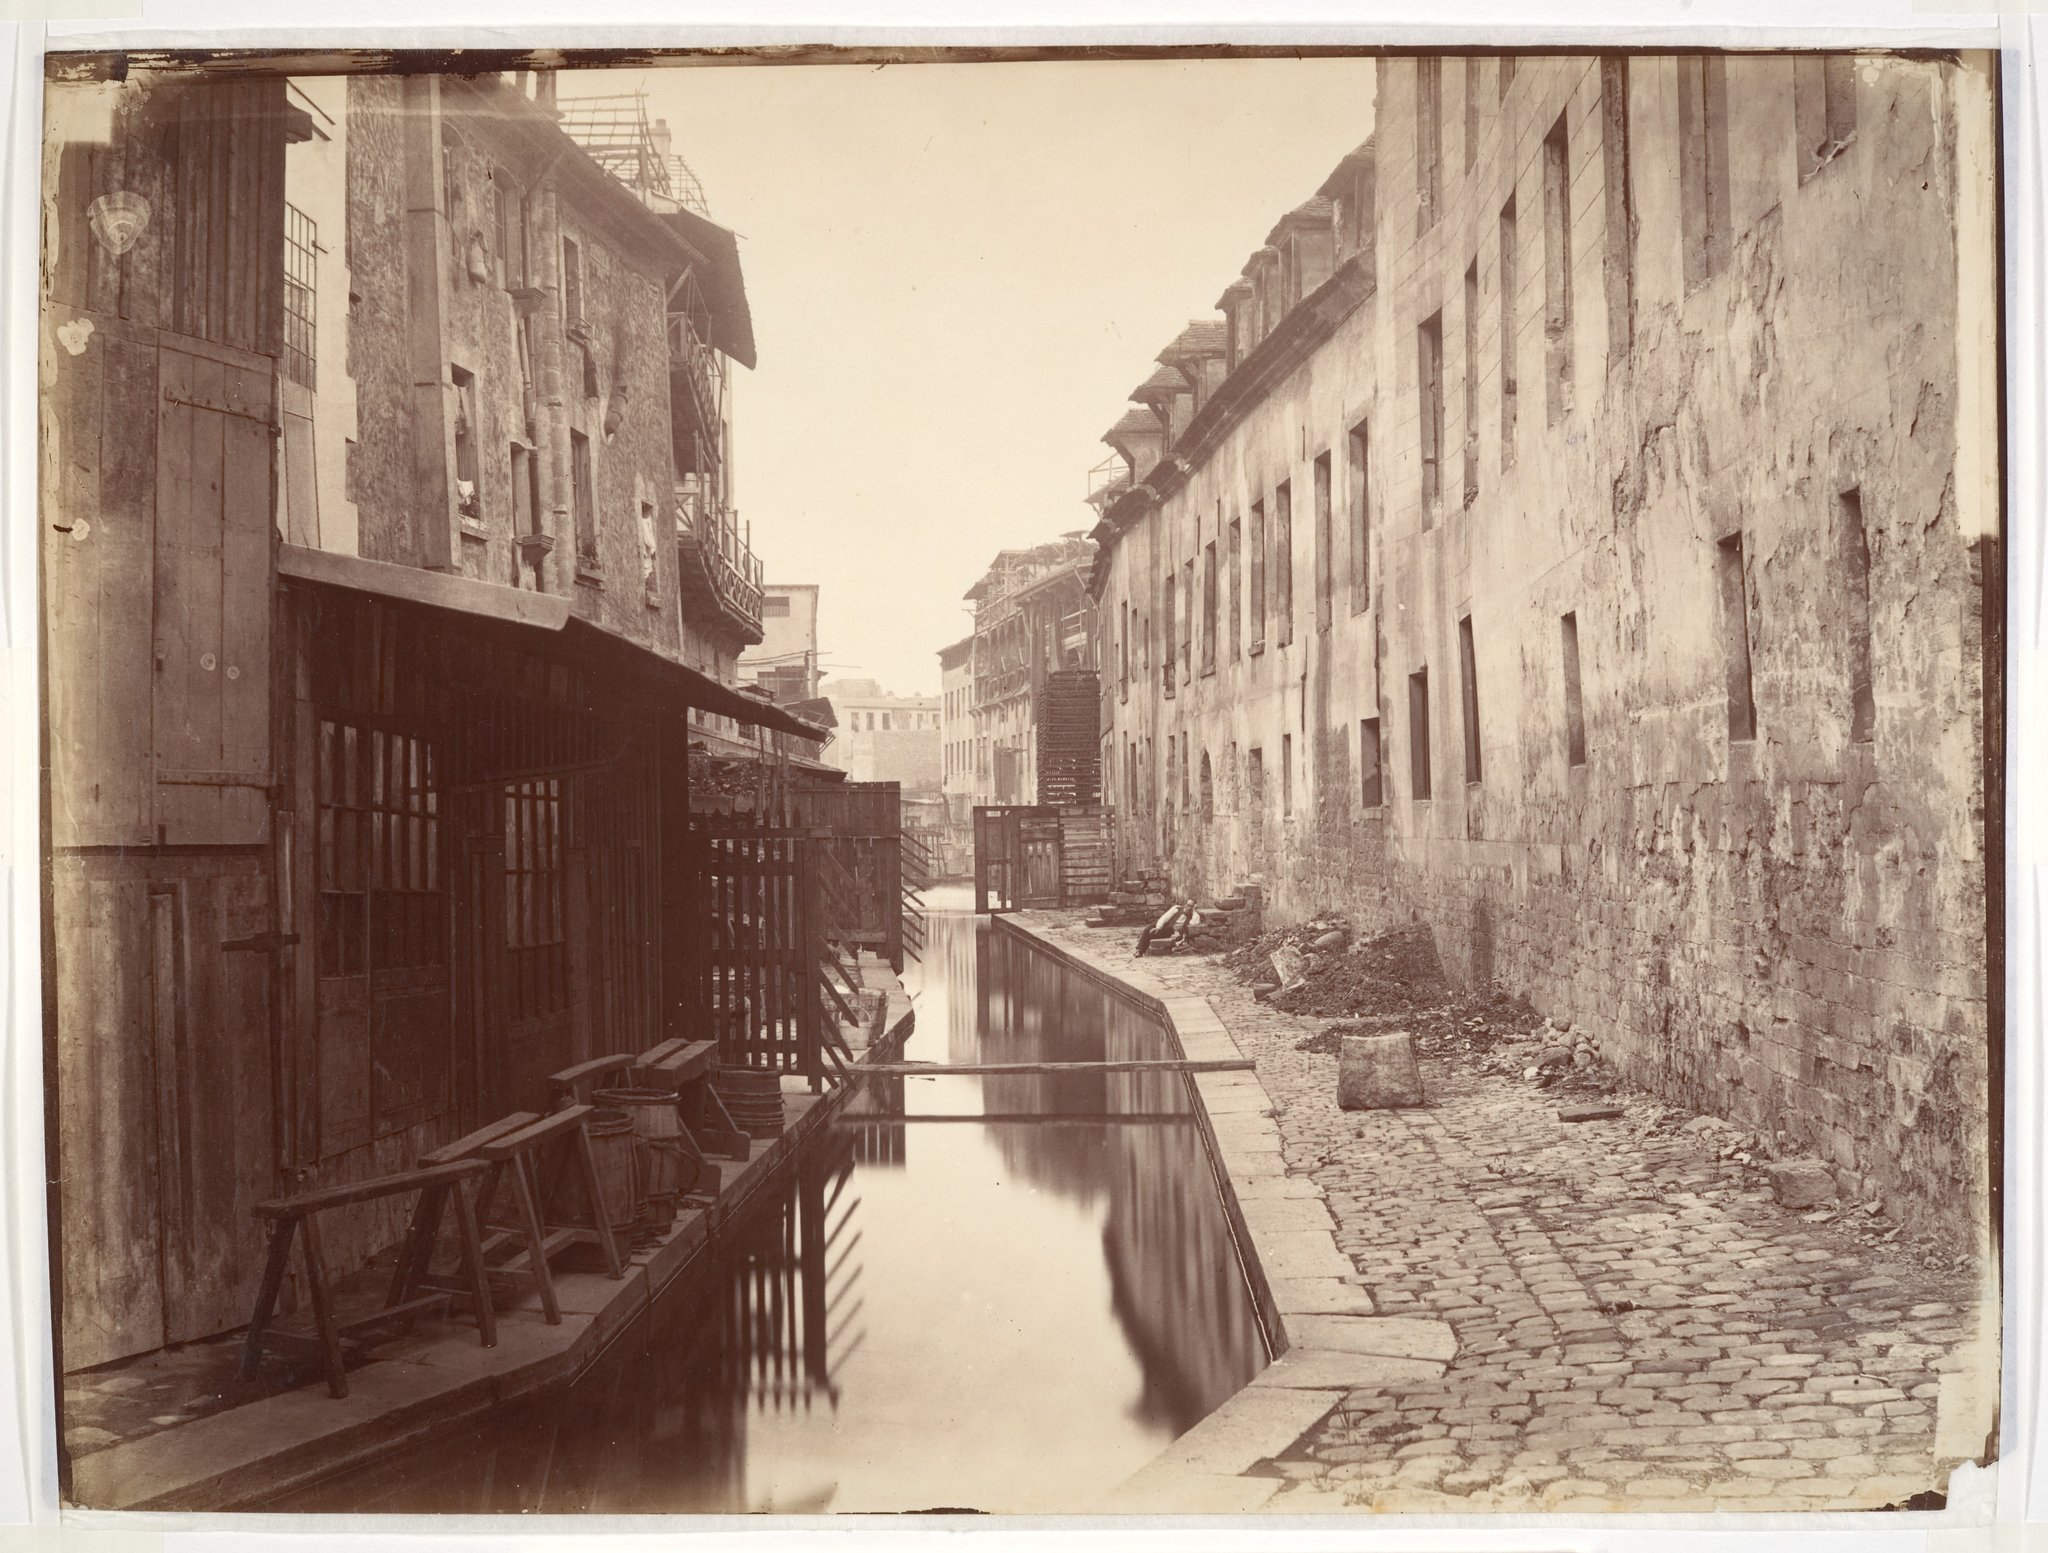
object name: photograph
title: La Bièvre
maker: charles marville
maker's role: artist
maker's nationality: french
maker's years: 1813-1879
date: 1862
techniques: albumen silver print, glass negative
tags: buildings,canals